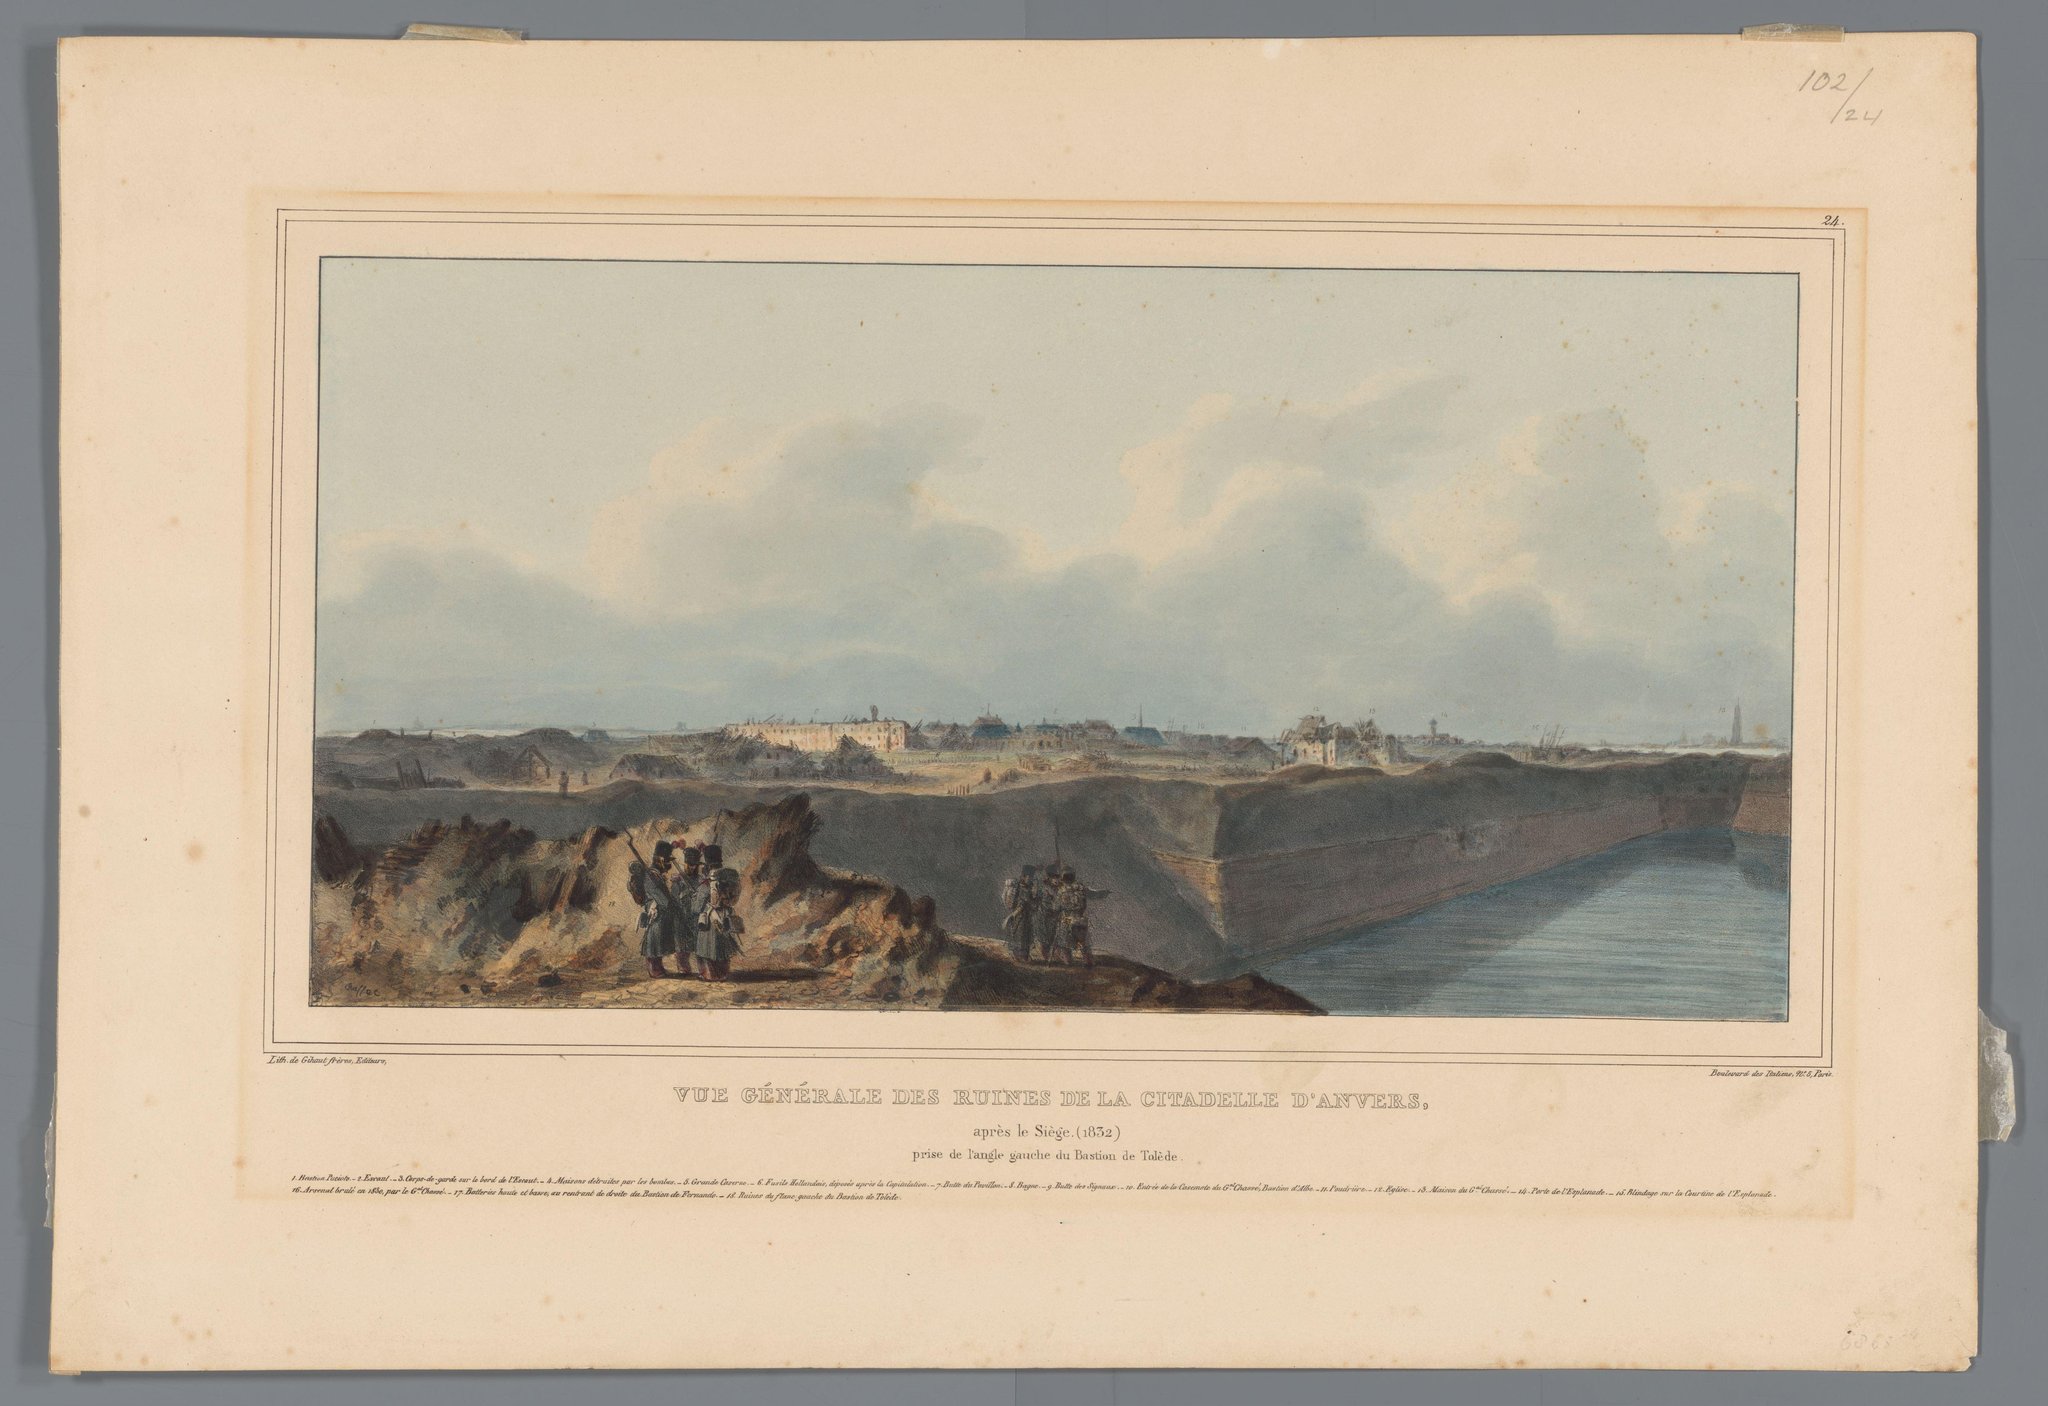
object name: print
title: Dessins faits d'après nature au siège de la Citadelle d'Anvers par Raffet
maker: denis auguste marie raffet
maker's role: draughtsman, print maker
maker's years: 1804-1860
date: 1833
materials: lacquer, paper, watercolor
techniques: hand coloring, lacquer, lithograph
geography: france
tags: raising the siege, devastated, ruined place or city (~ warfare), antwerp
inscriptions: signature: ‘Raffet’, caption: ‘VUE GENERALE DES RUINEN DE LA CITADELLE D'ANVERS, / après le Siège. (1832) / prise de l'angle gauche du Bastion de Tolède. (+ legenda)’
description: Gezicht op ruines van de Citadel van Antwerpen na het beleg. Op de voorgrond enkele militairen. Rechtsvoor water. Met legenda 1-18. Onderdeel van de serie van 24 prenten over het beleg van de Citadel van Antwerpen, 30 november - 23 december 1832.